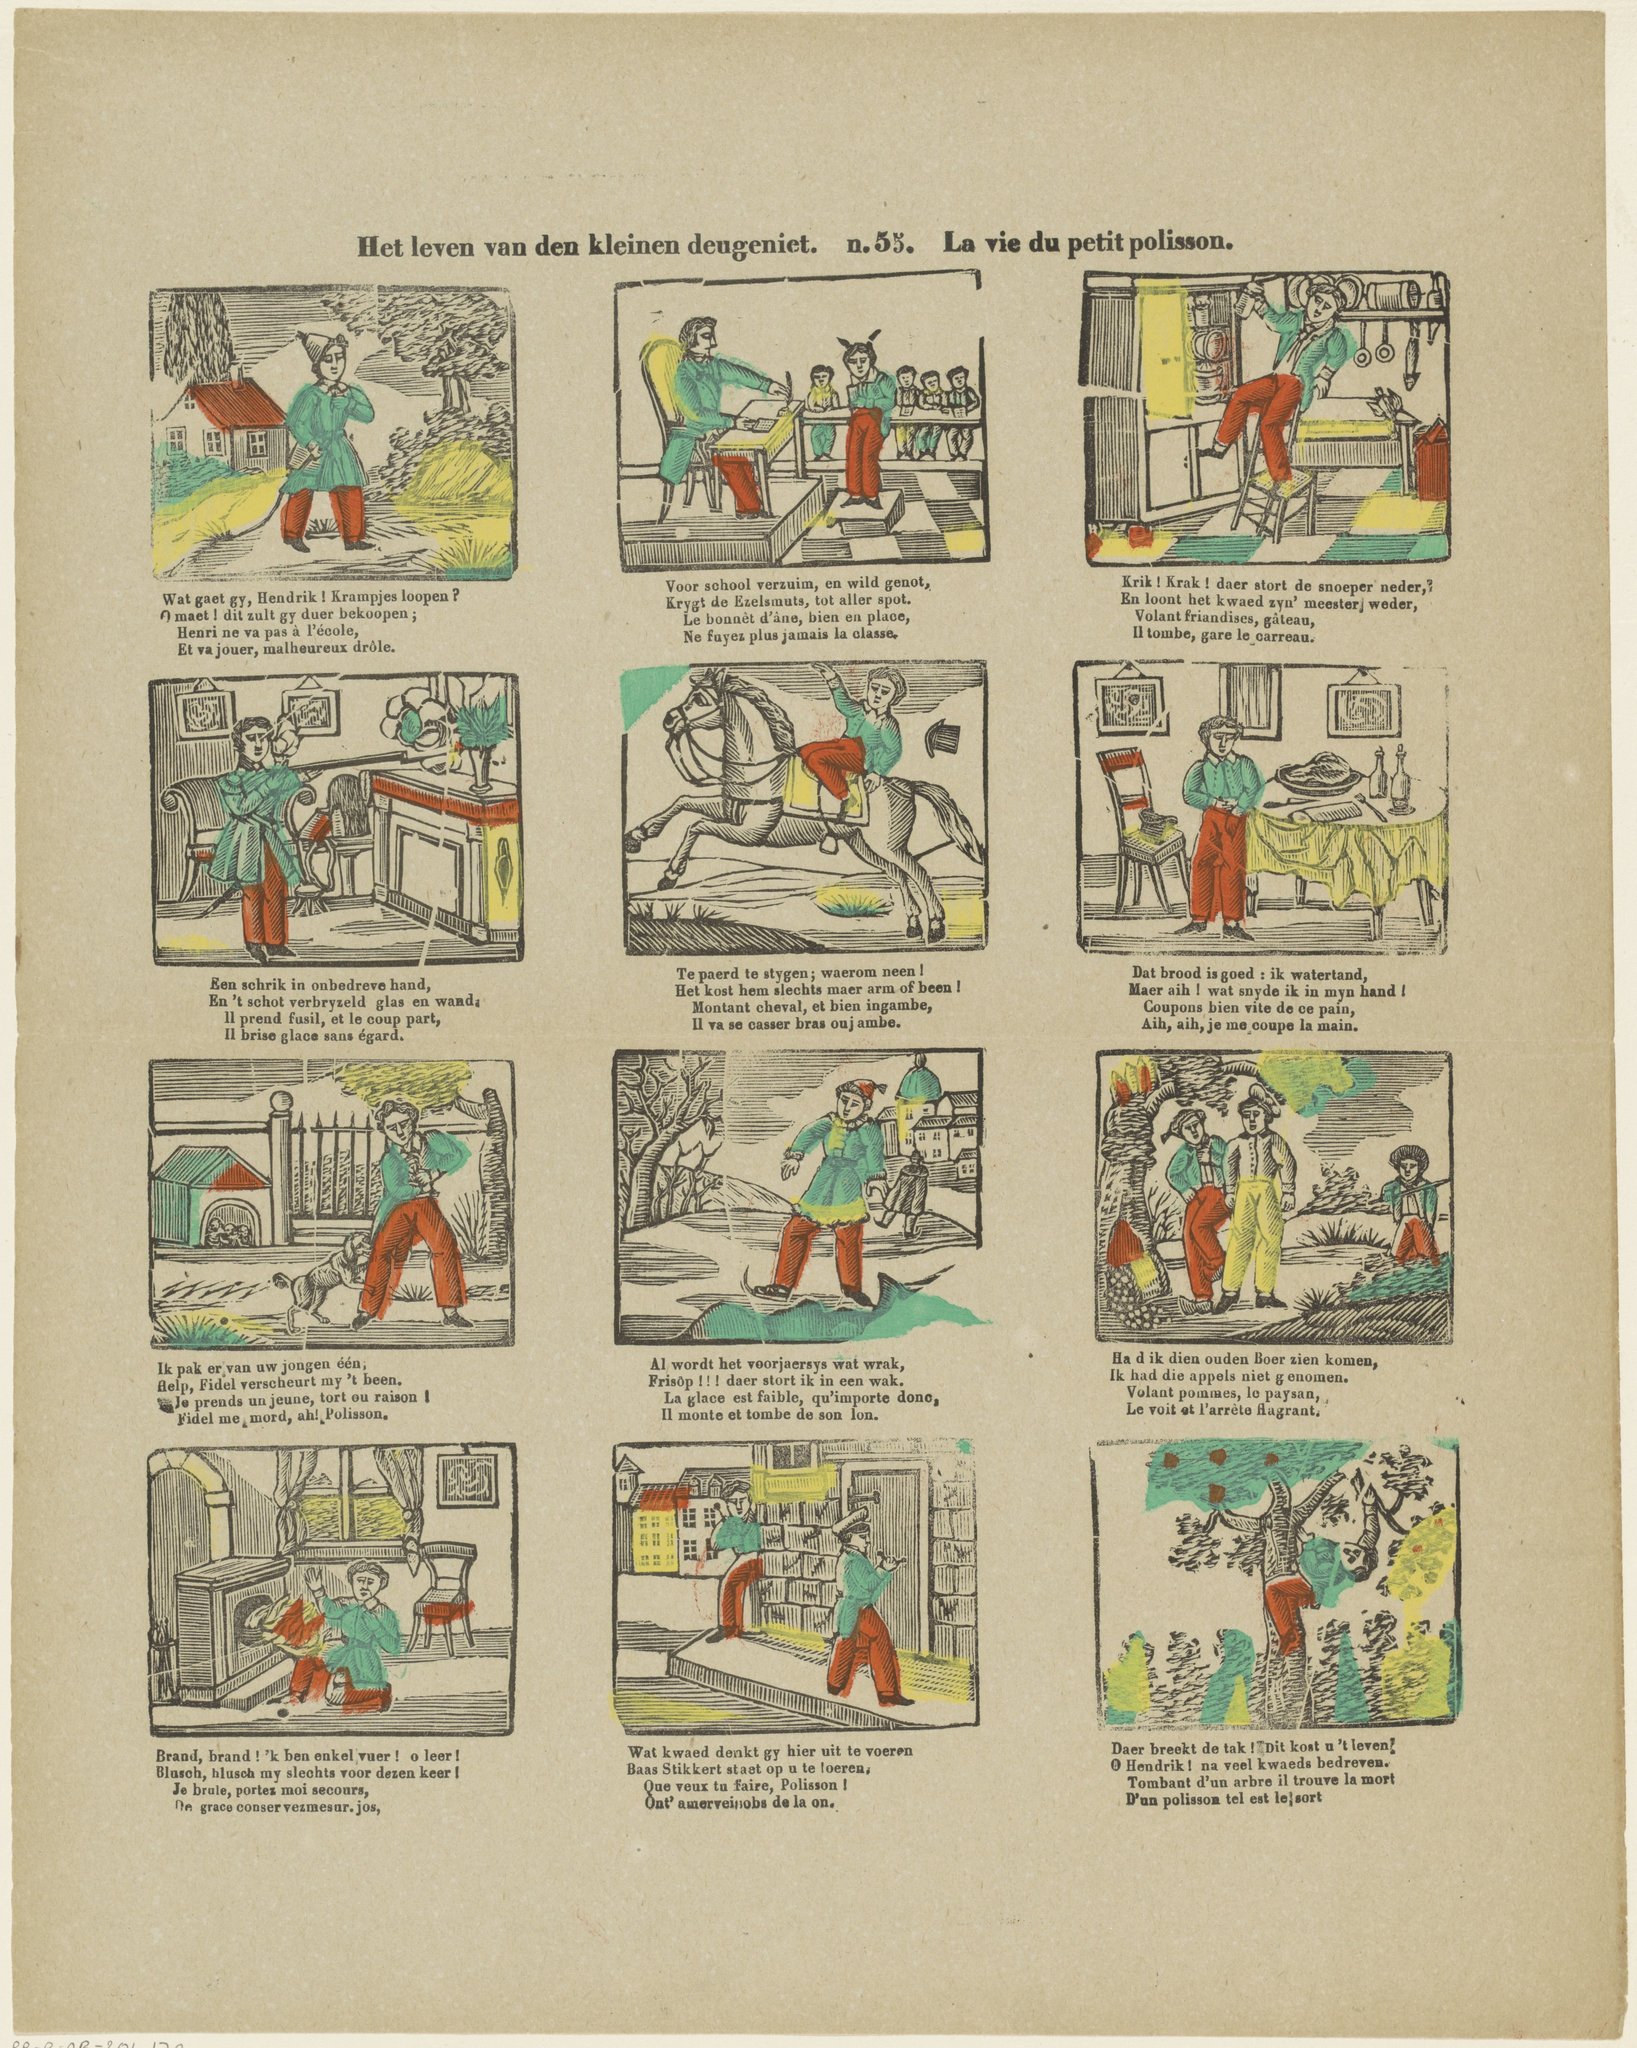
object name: print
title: Het leven van den kleinen deugeniet / La vie du petit polisson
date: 1866-1902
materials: paper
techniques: colour, letterpress printing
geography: europe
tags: mischief-making play, child, bad behaviour, little household accidents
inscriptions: collector's mark: Lugt 2760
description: Blad met 12 voorstellingen van de streken en ongelukken van de kleine deugniet Hendrik. Onder elke voorstelling een tweeregelig vers in het Nederlands en het Frans. Genummerd midden boven: n. 55.